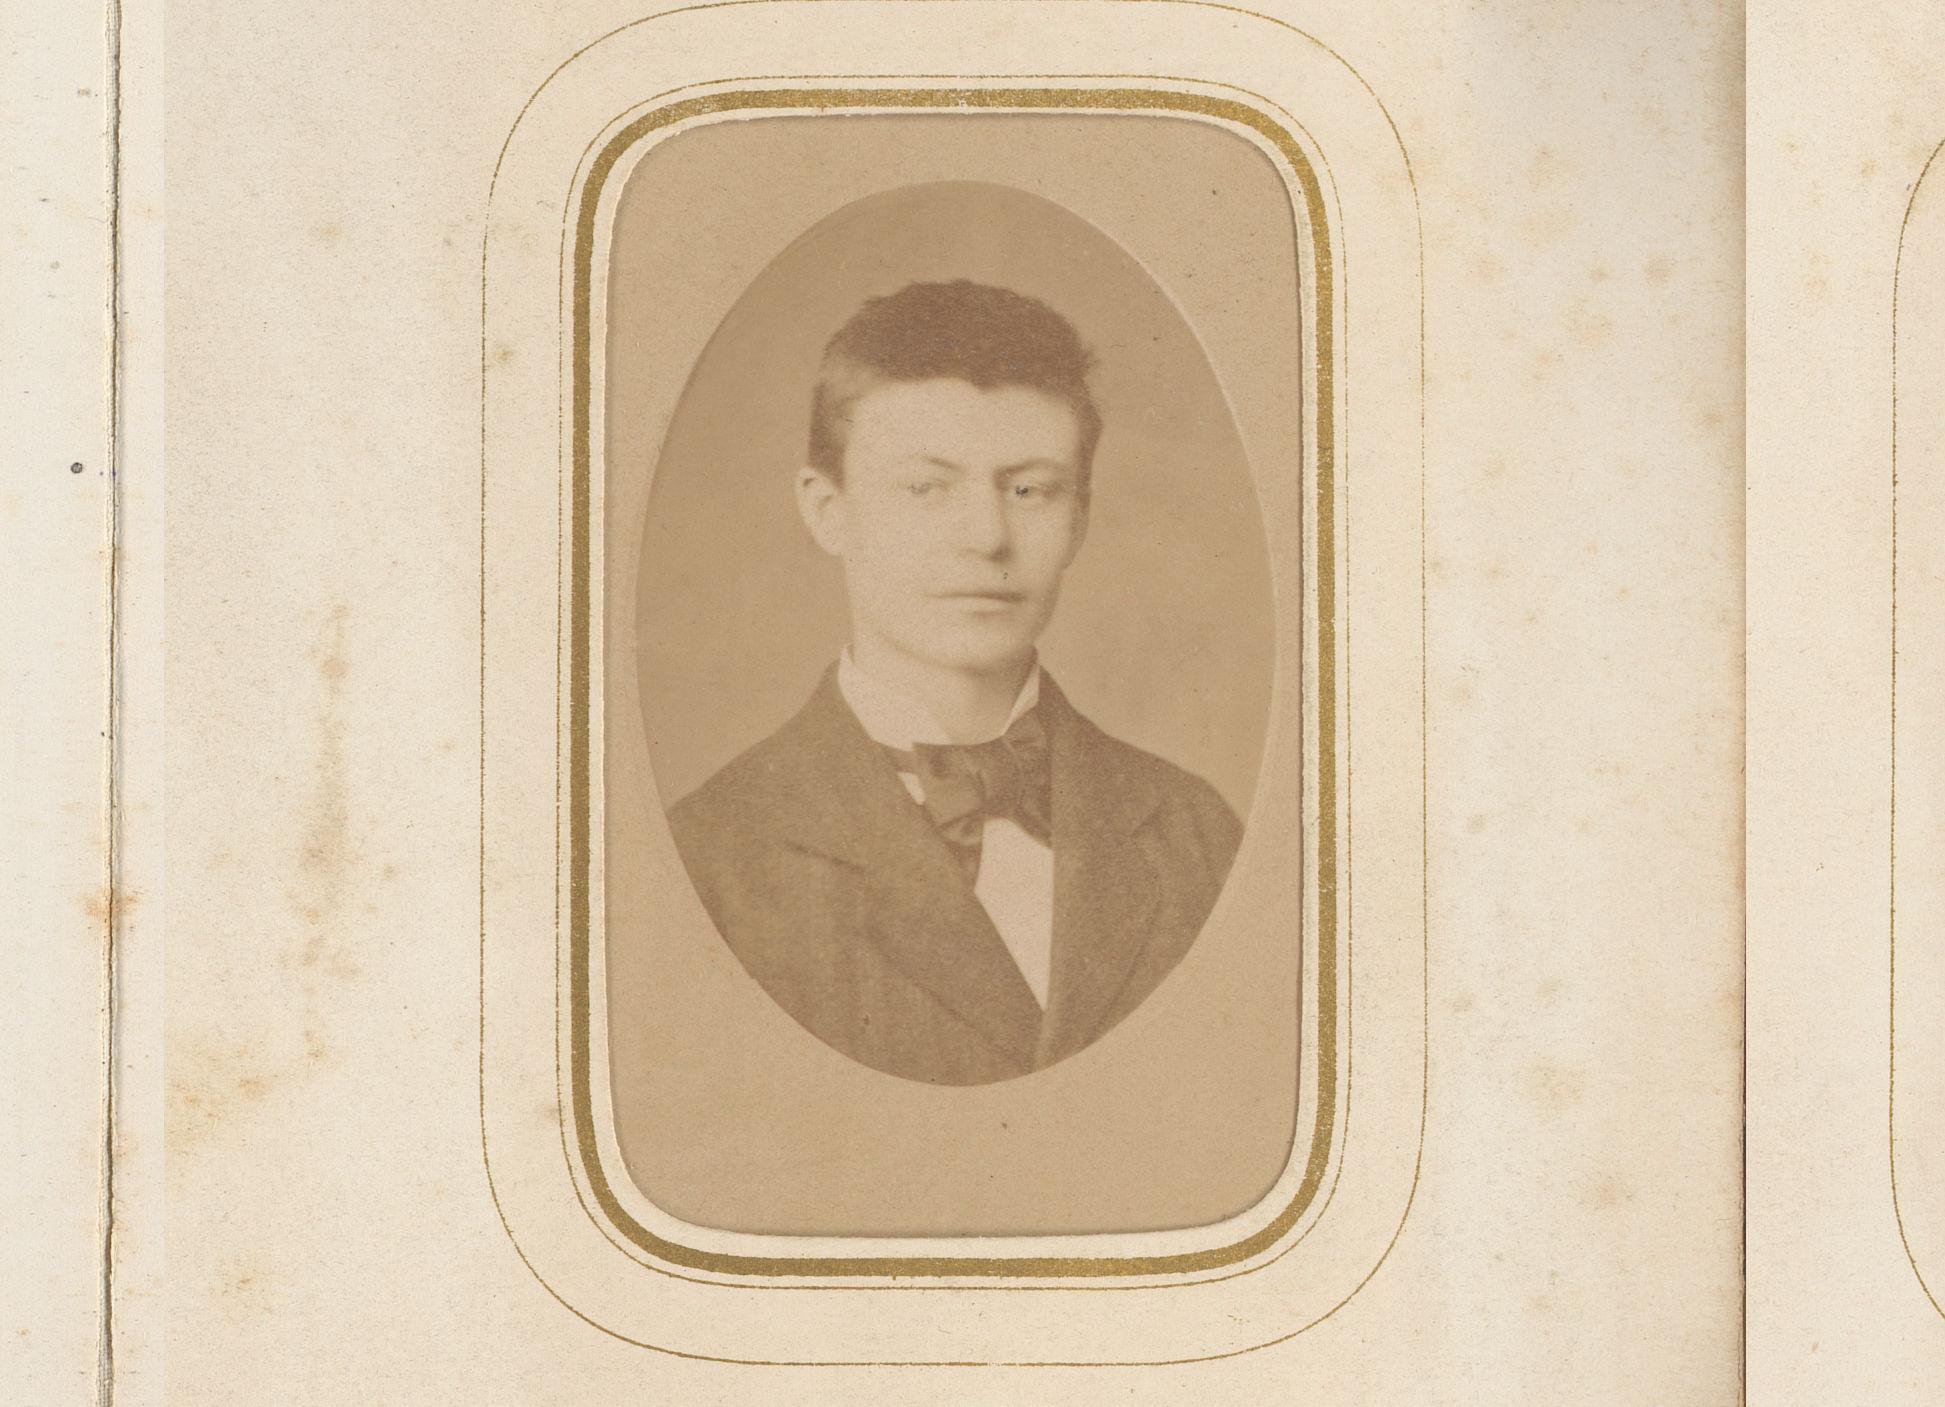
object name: carte de visite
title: Portret van een jongeman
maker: Anonymous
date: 1880-1900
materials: cardboard, photographic support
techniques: albumen print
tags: historical persons, youth, adolescent